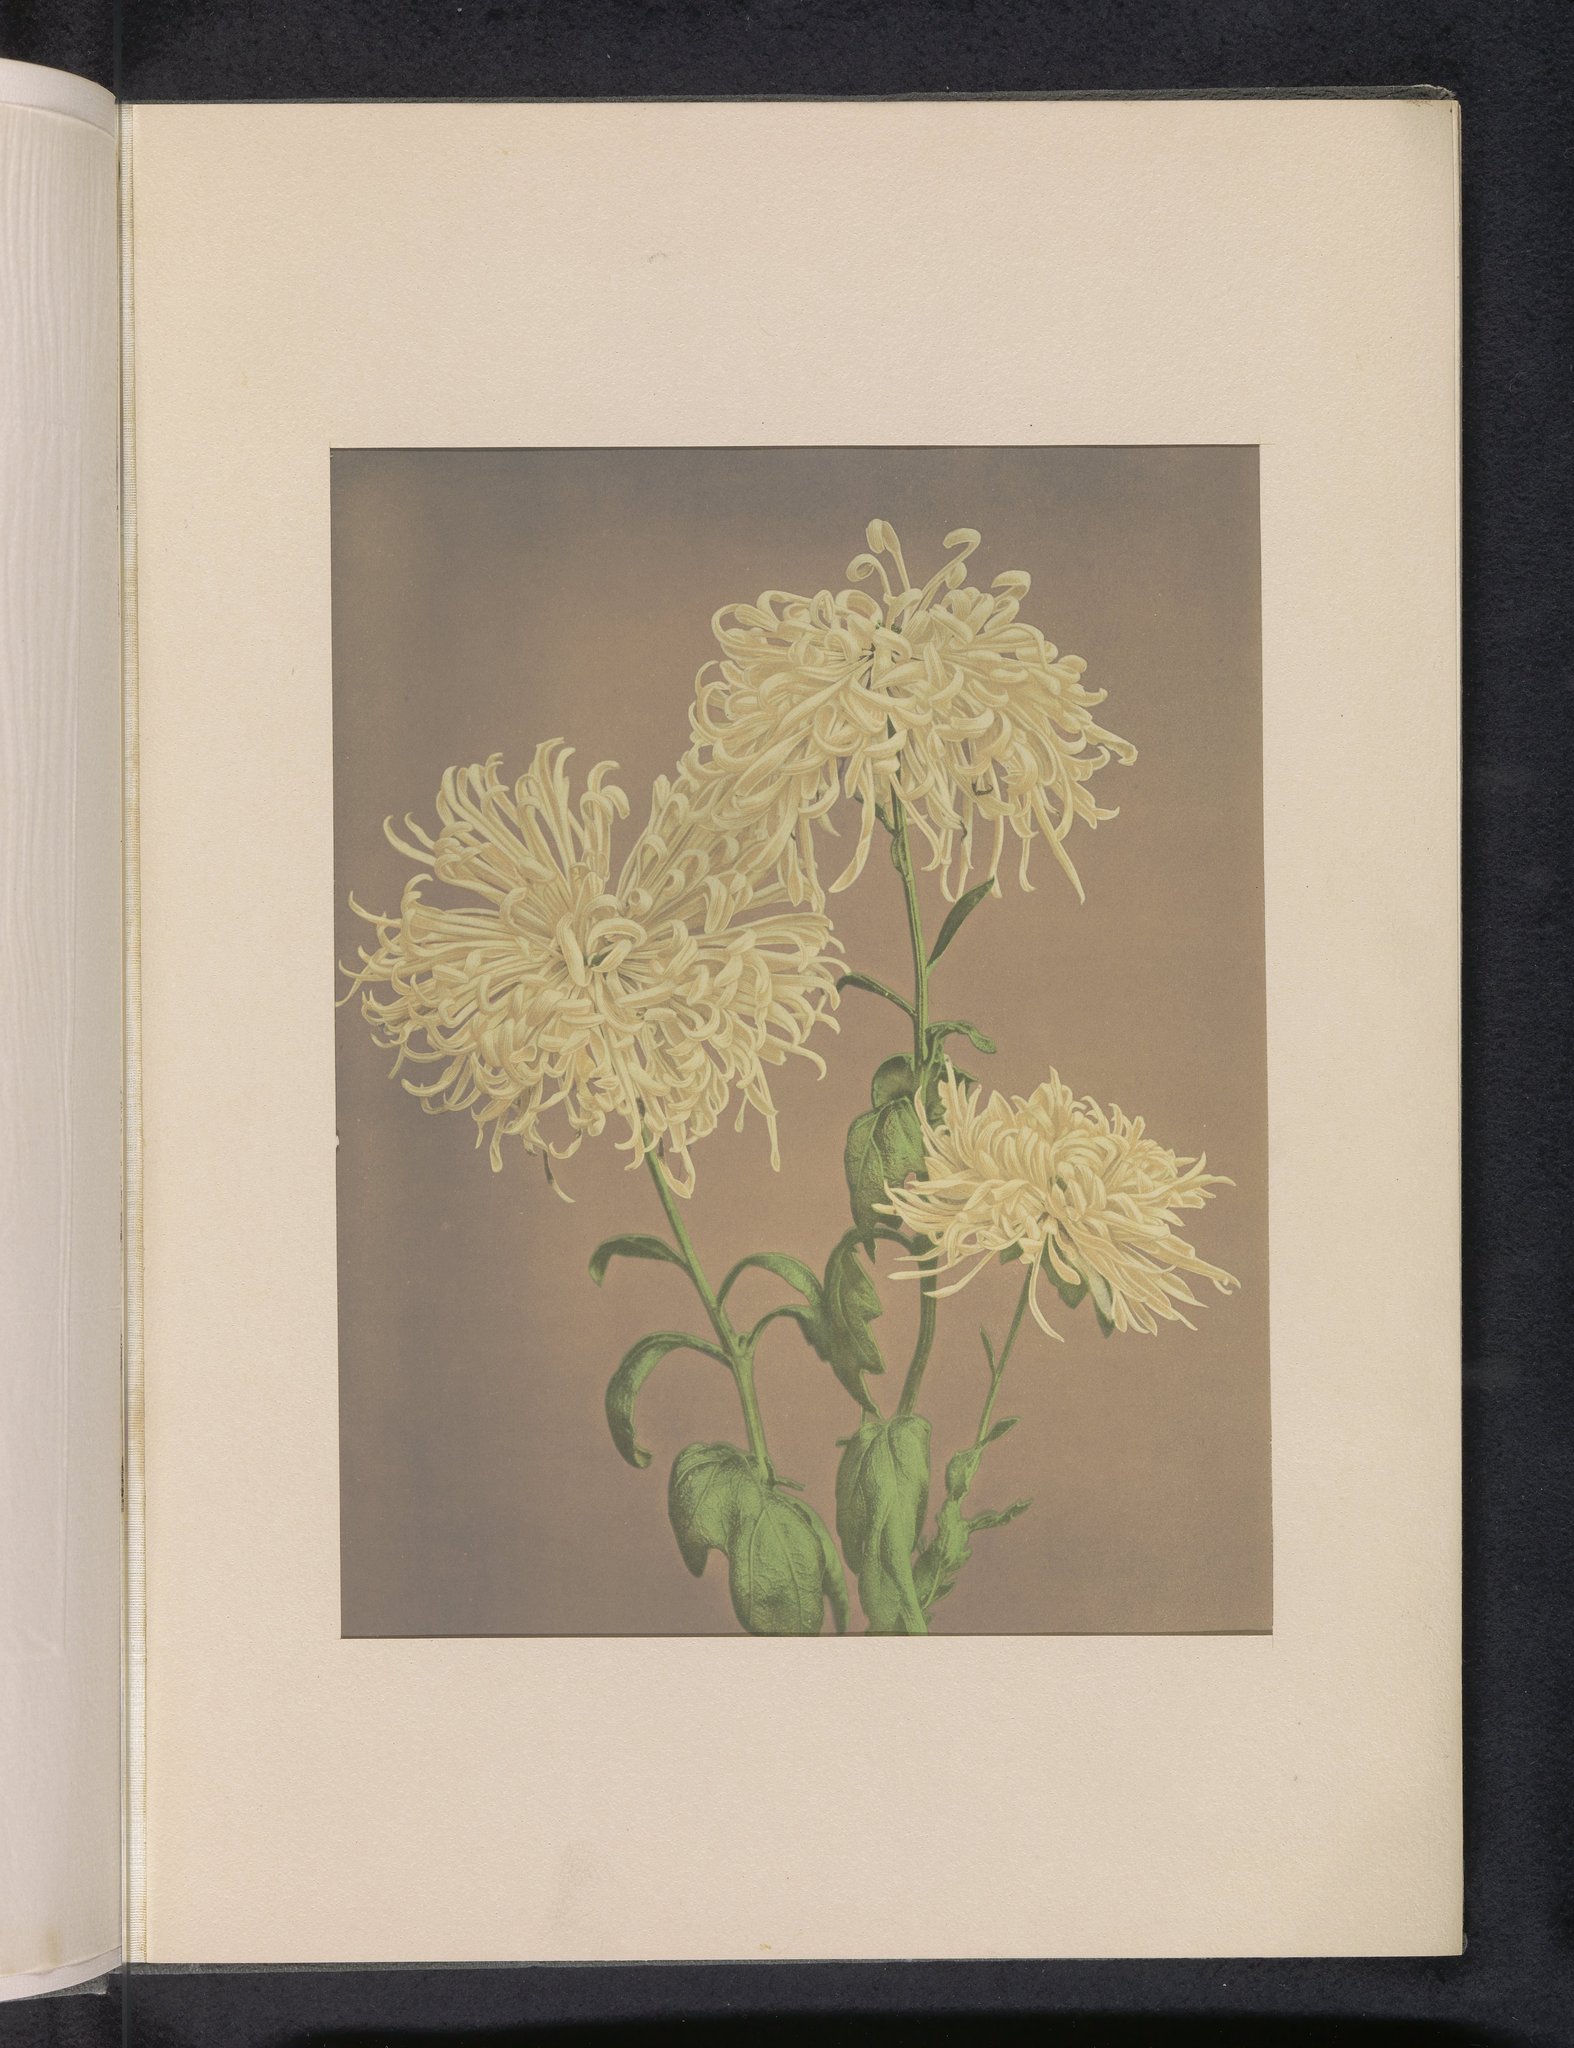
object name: photomechanical print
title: Drie gele chrysanten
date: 1887-1897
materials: paper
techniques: photograph, hand coloring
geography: japan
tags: flowers